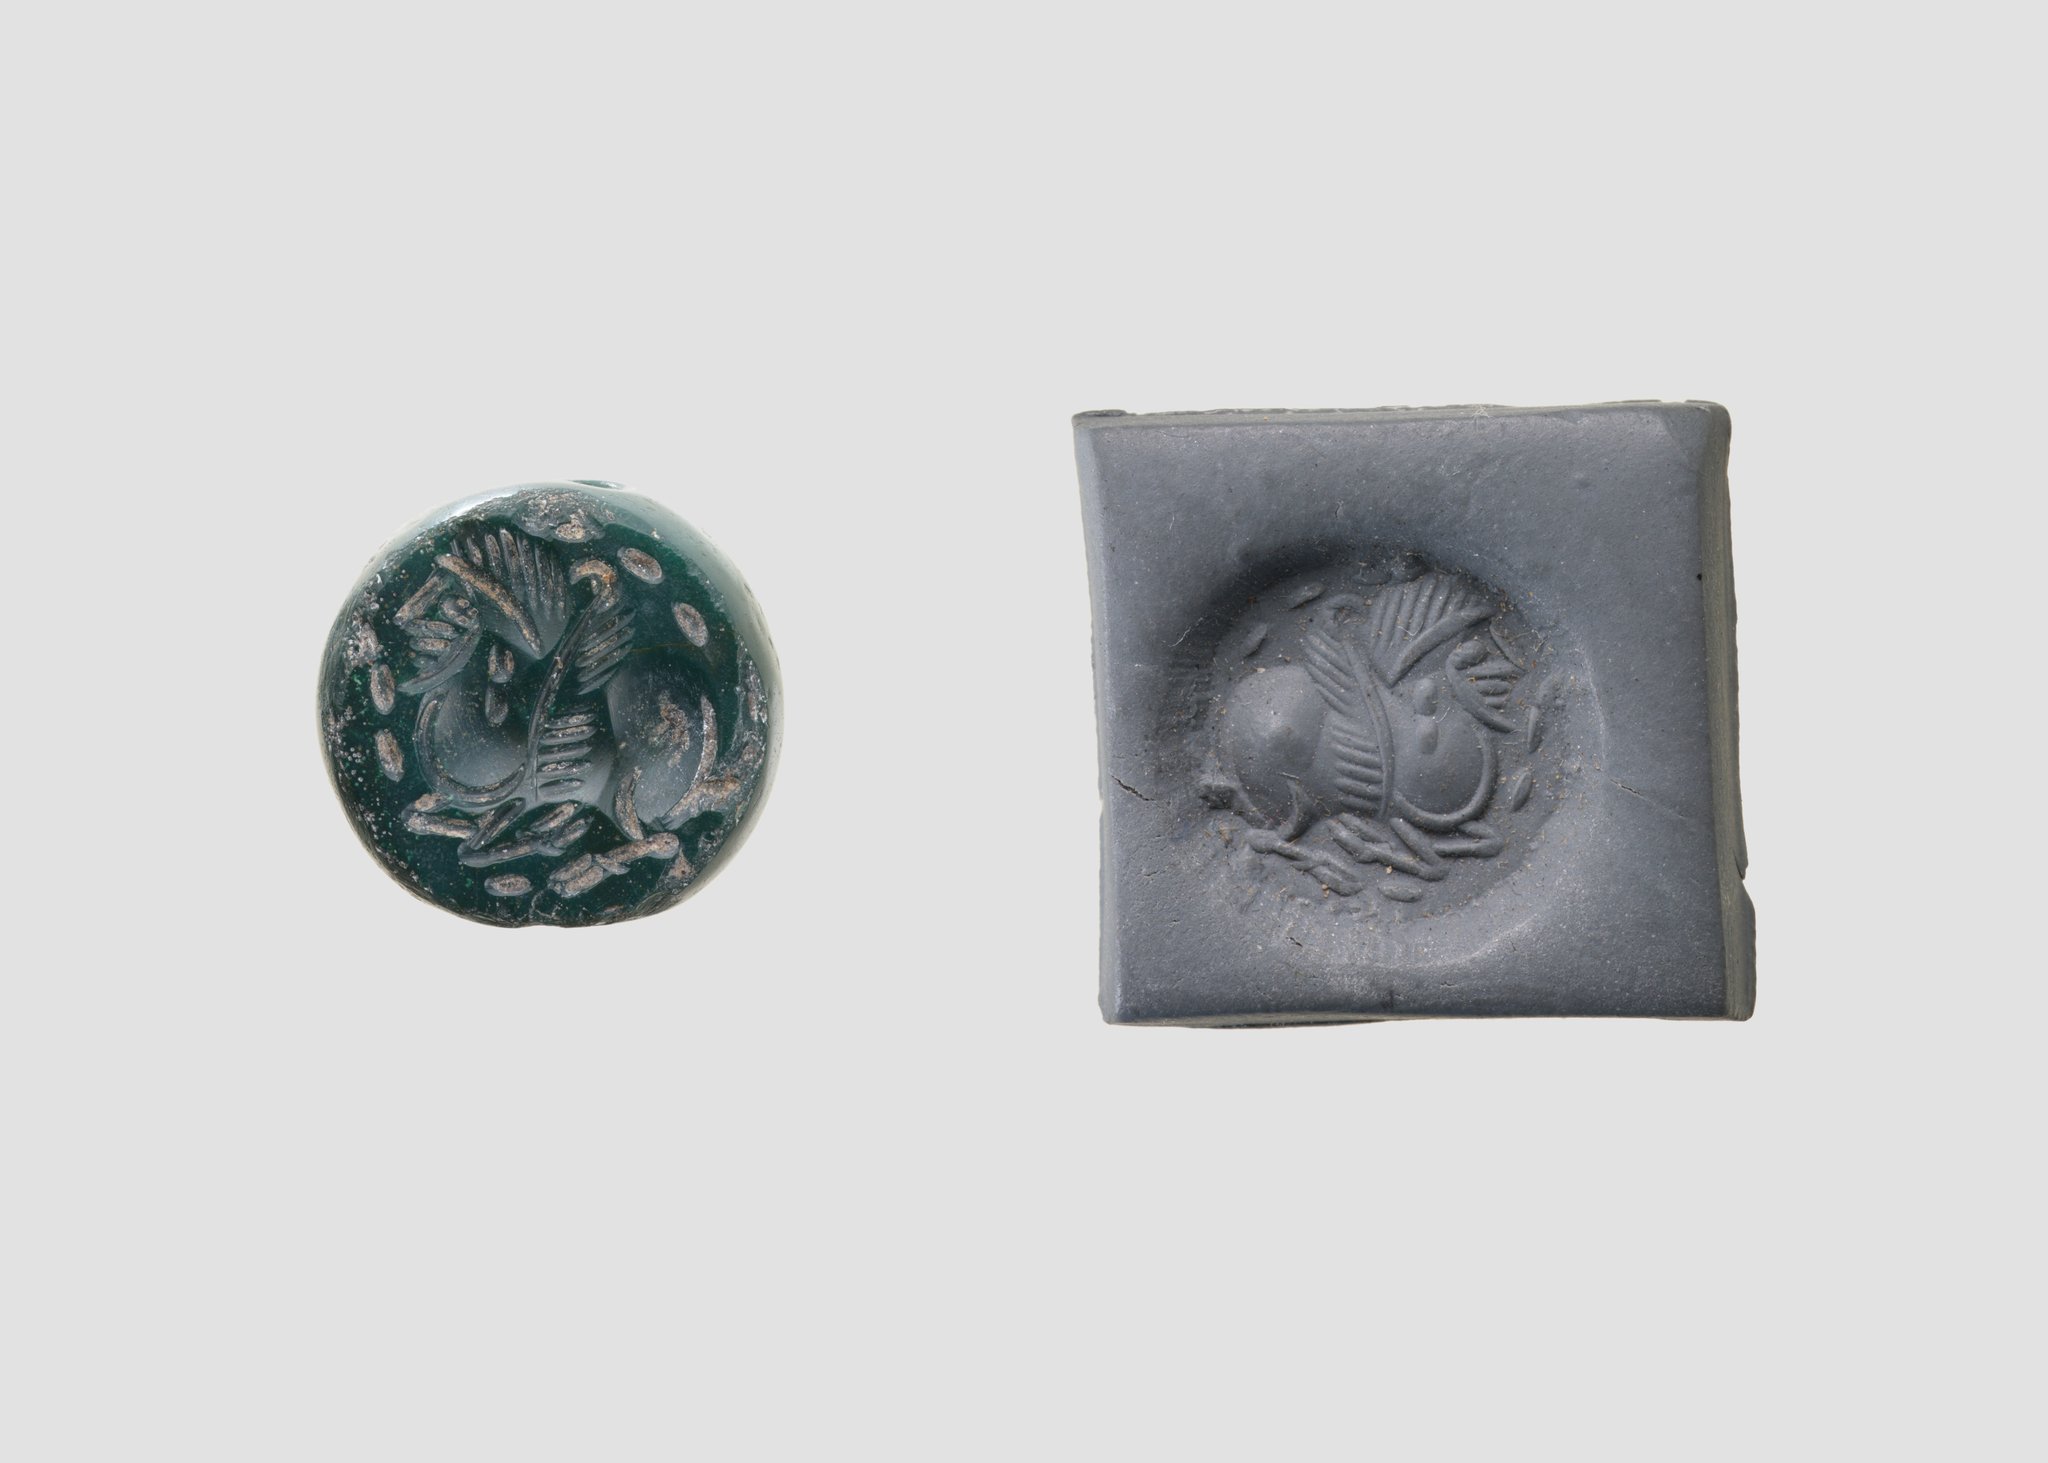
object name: stamp seal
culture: sasanian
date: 201-700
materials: jasper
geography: iran